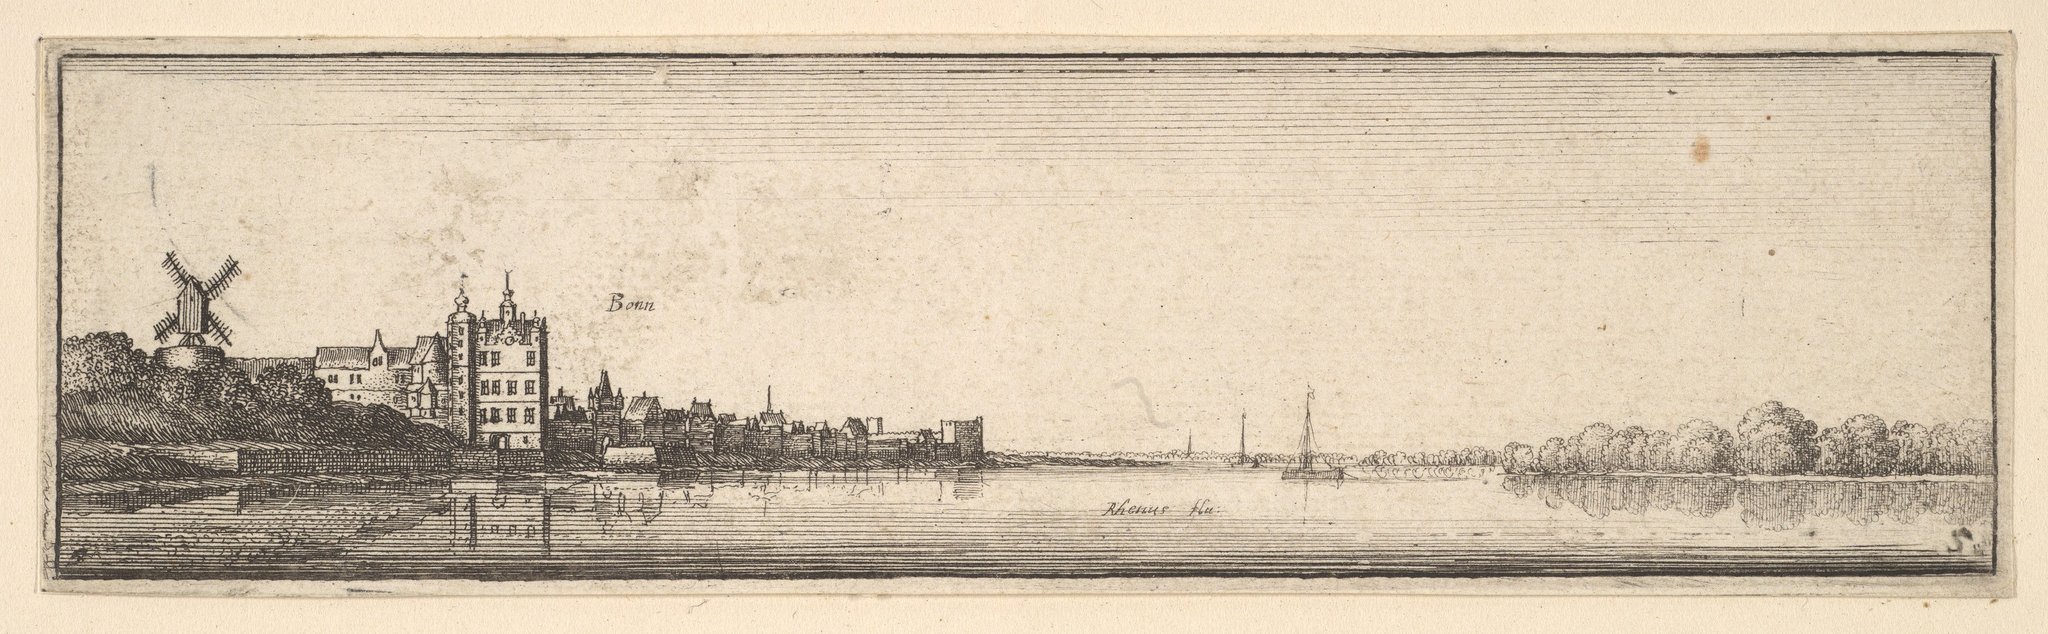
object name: print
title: Bonn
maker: wenceslaus hollar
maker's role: artist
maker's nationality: bohemian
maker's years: 1607-1677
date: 1642-1644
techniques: etching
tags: buildings,windmills,rivers